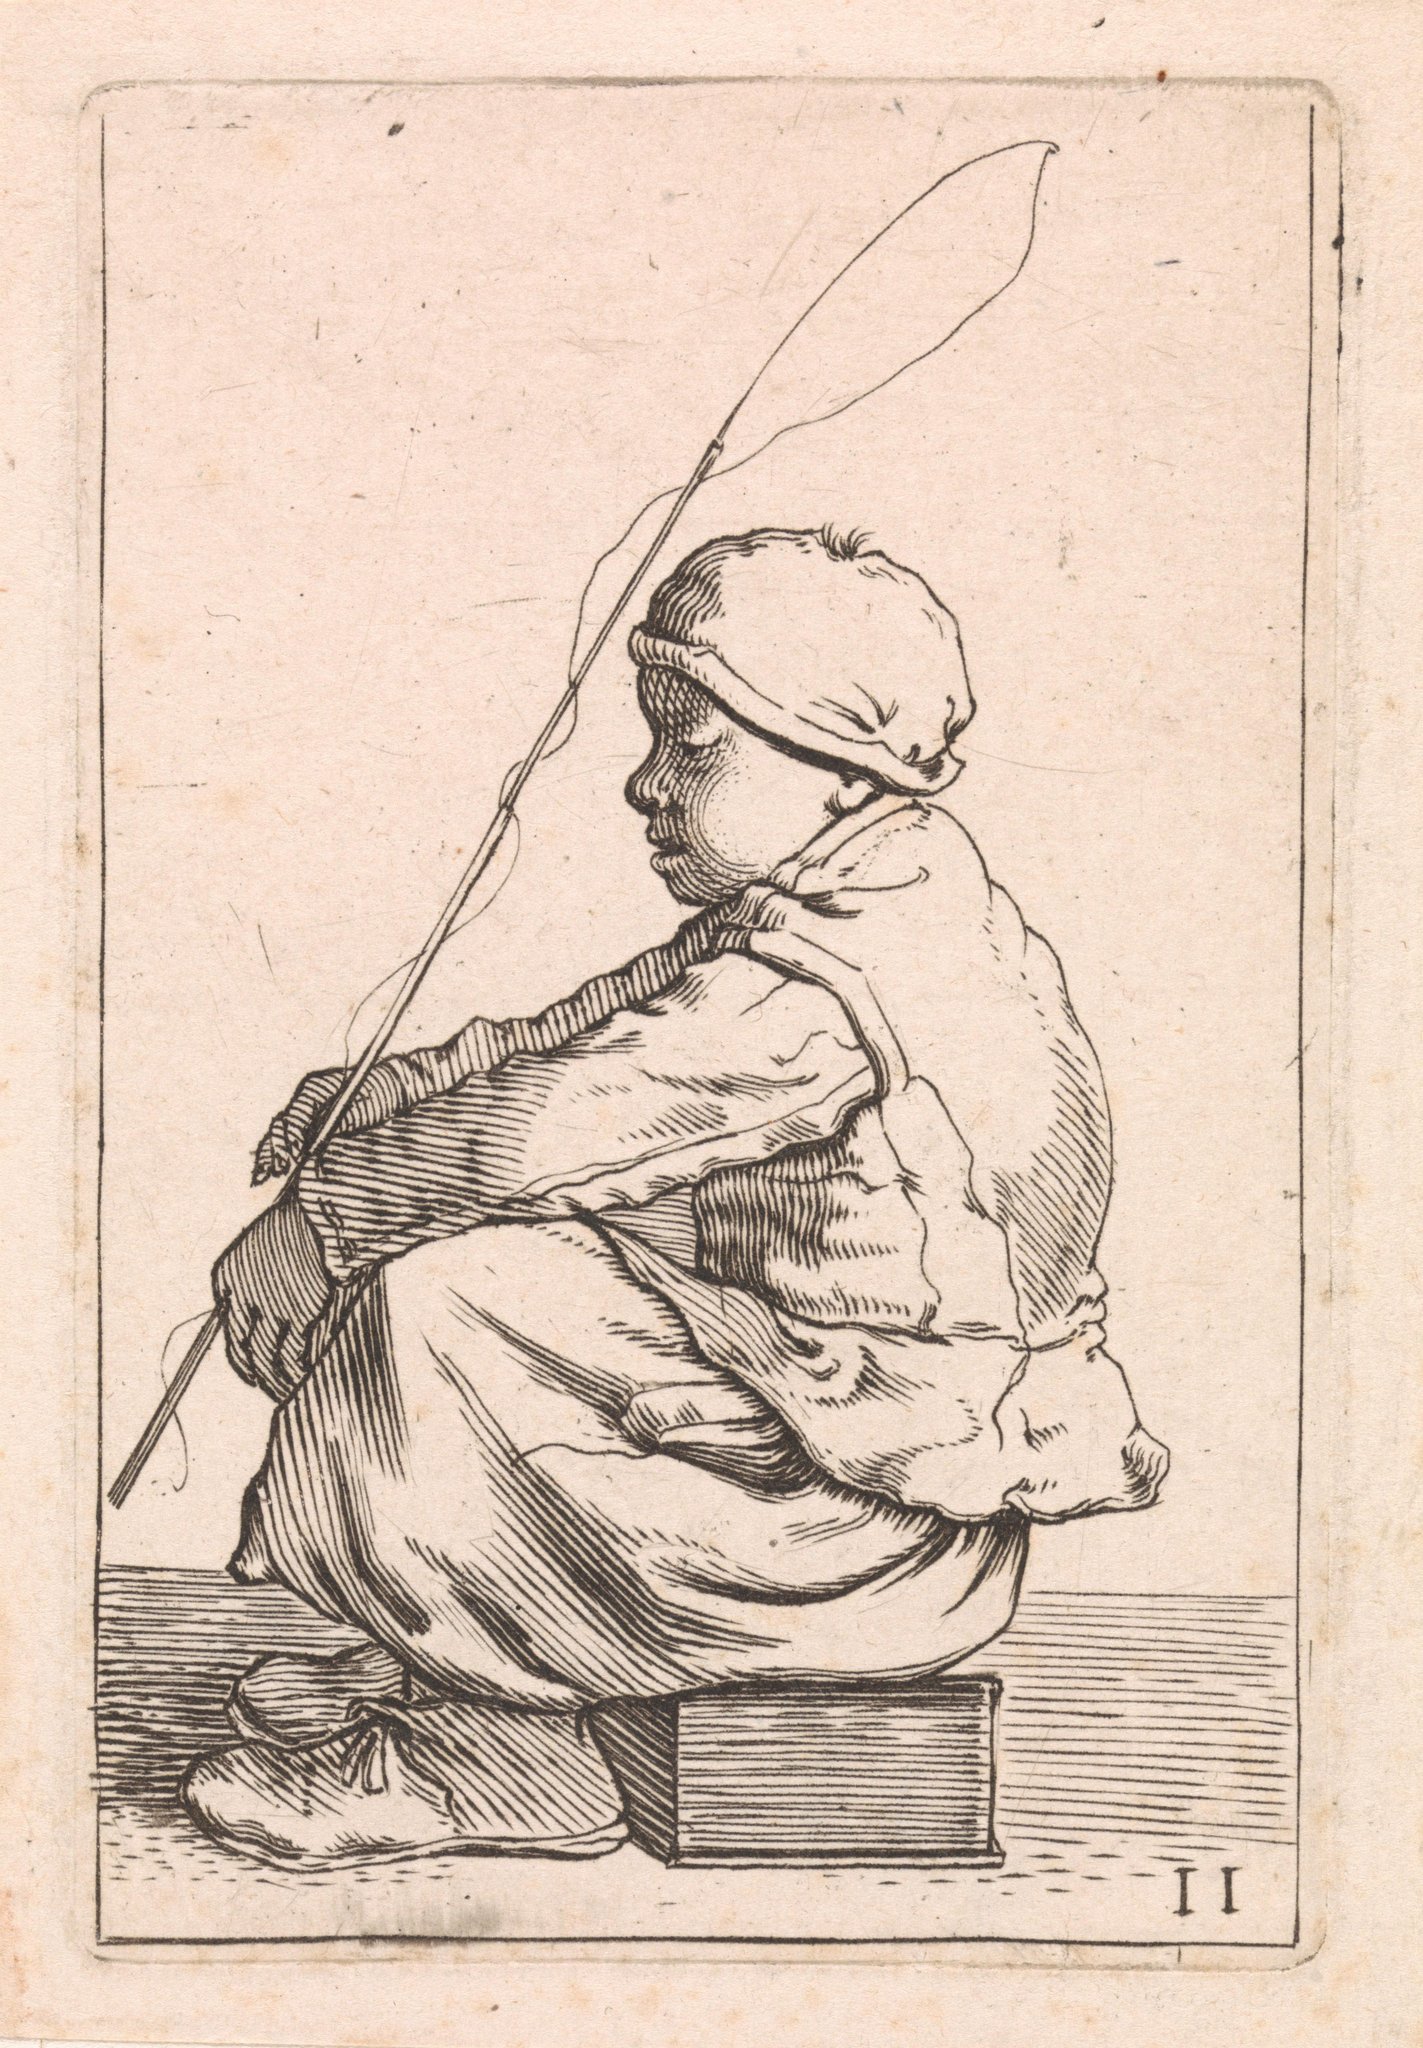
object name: print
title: Zittende jongen met vishengel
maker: cornelis saftleven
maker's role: draughtsman, painter, print maker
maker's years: 1607-1681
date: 1645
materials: paper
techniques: etching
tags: farmers, angling, fisherman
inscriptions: collector's mark: Lugt 240